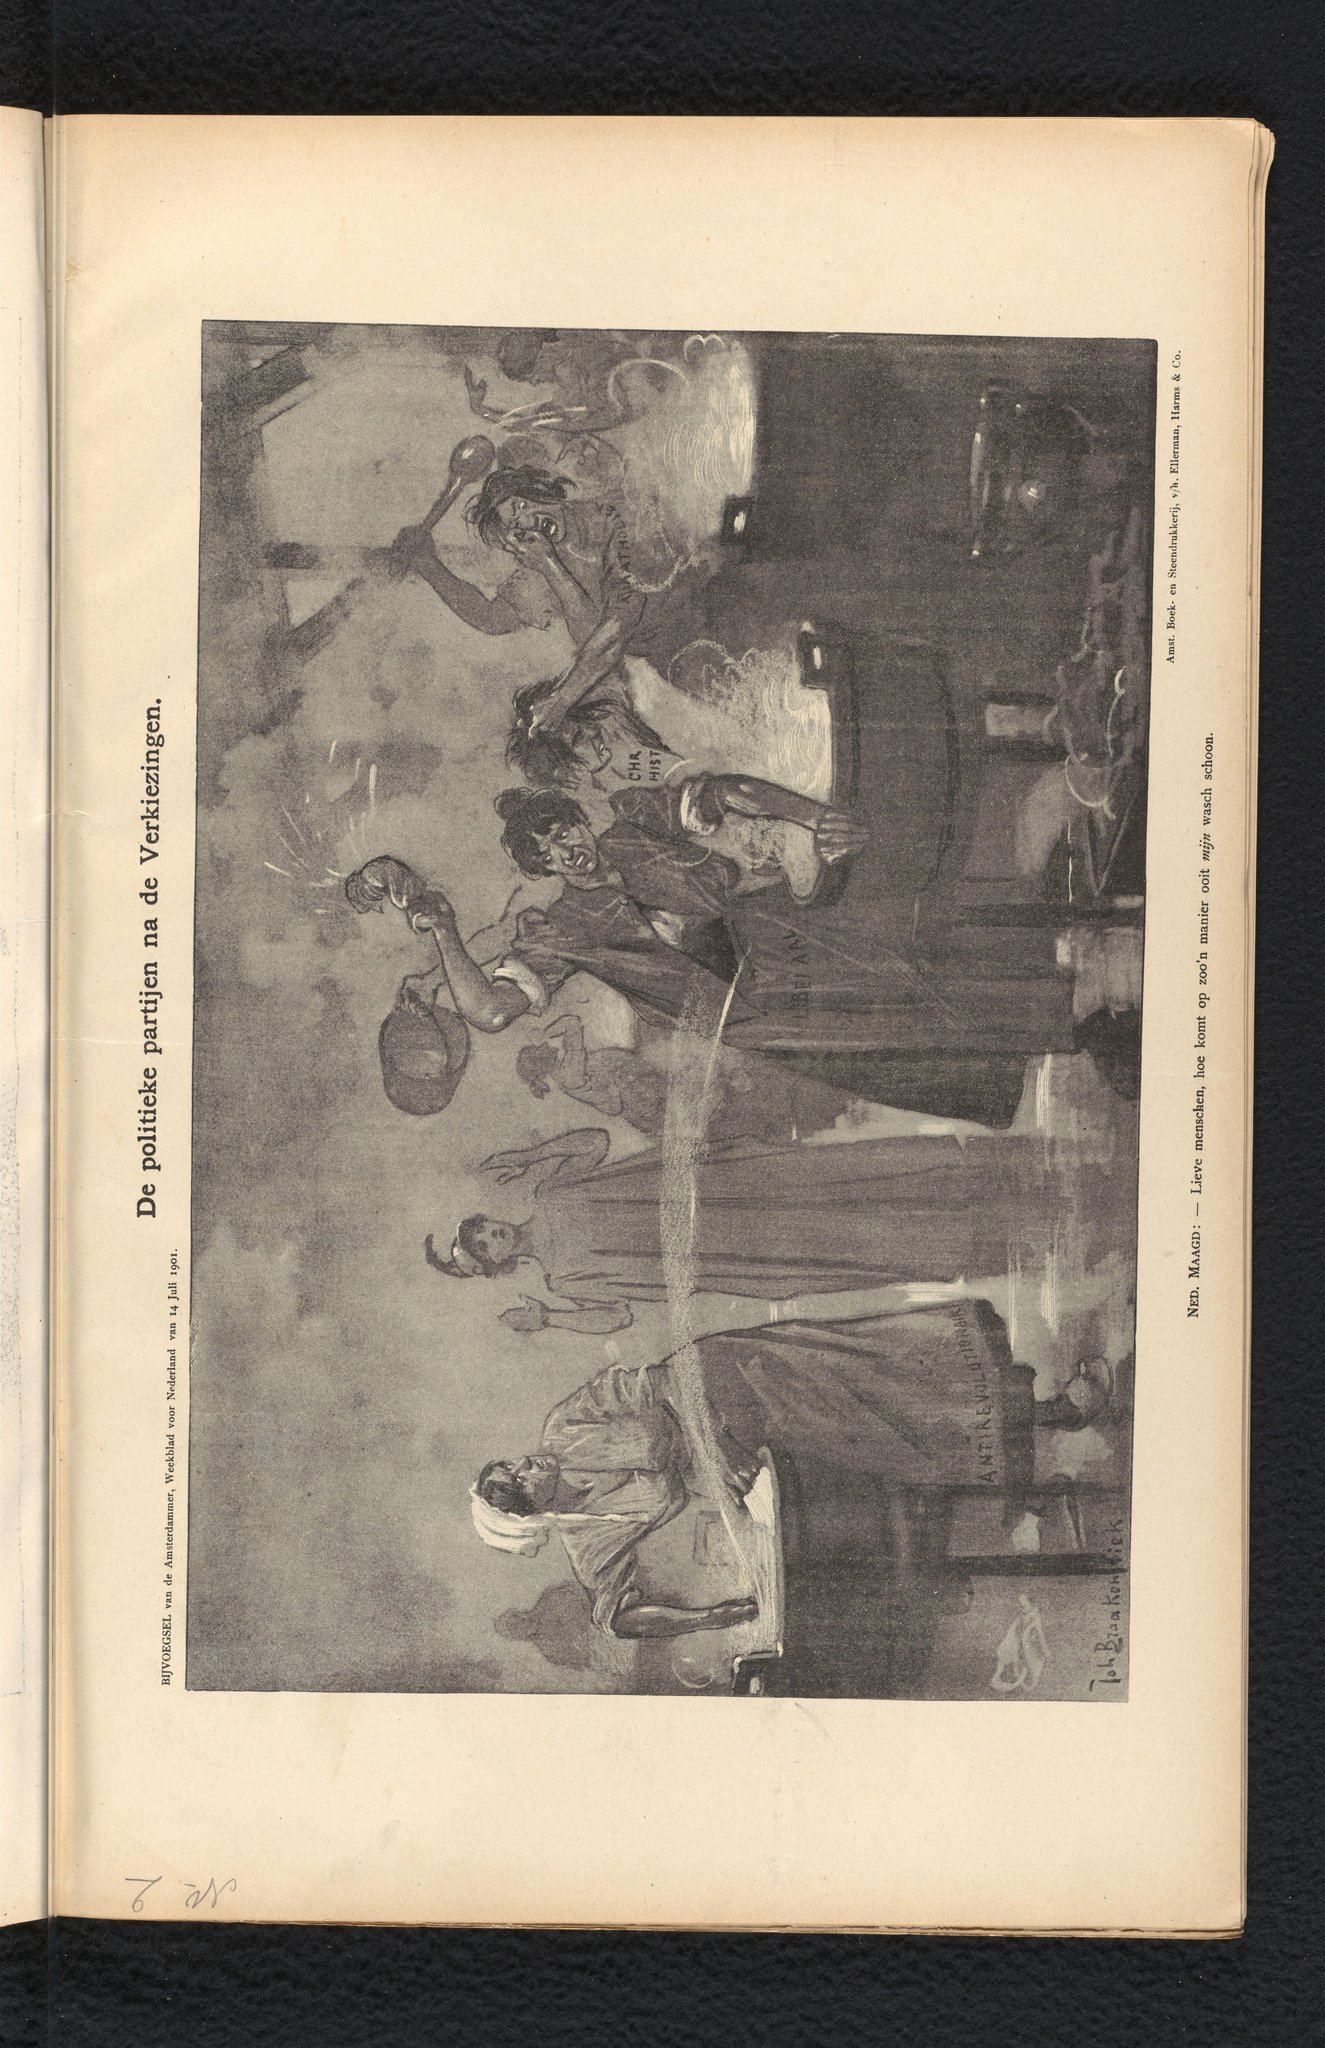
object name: cartoon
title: De politieke partijen na de Verkiezingen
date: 1901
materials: paper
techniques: autotype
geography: amsterdam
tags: voting, election, personifications of countries, nations, states, districts, etc., public wash house, fighting, political caricatures and satires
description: De Nederlandse politieke partijen als vechtende wasvrouwen, na de Tweede Kamerverkiezingen van juni 1901. De Nederlandse Maagd maakt zich zorgen.